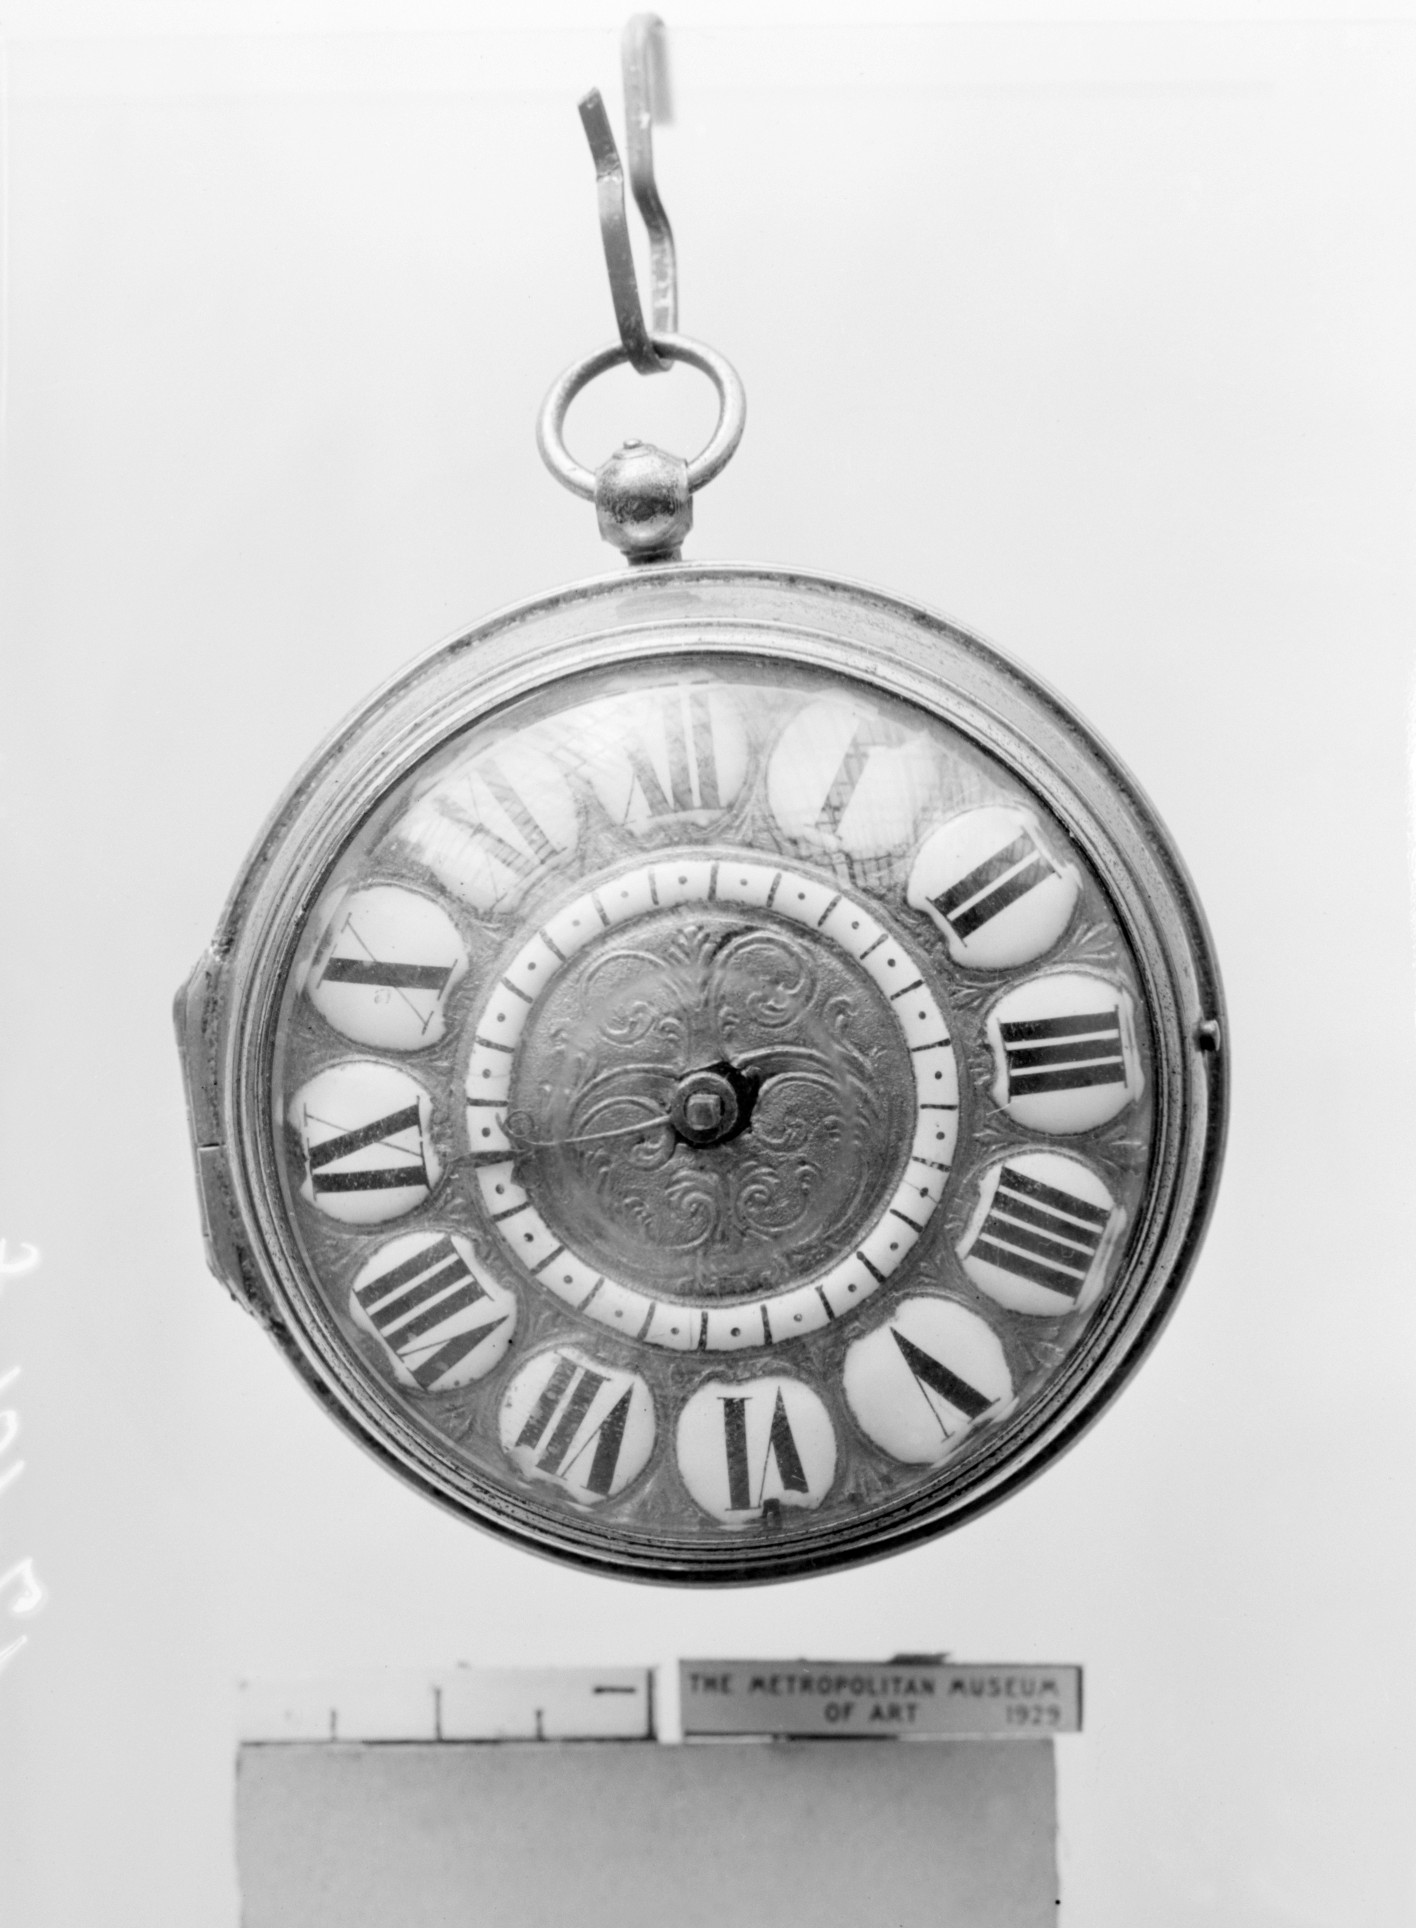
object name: watch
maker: bernard hubert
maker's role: maker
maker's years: 1707-1710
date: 1701-1800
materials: brass, gilt